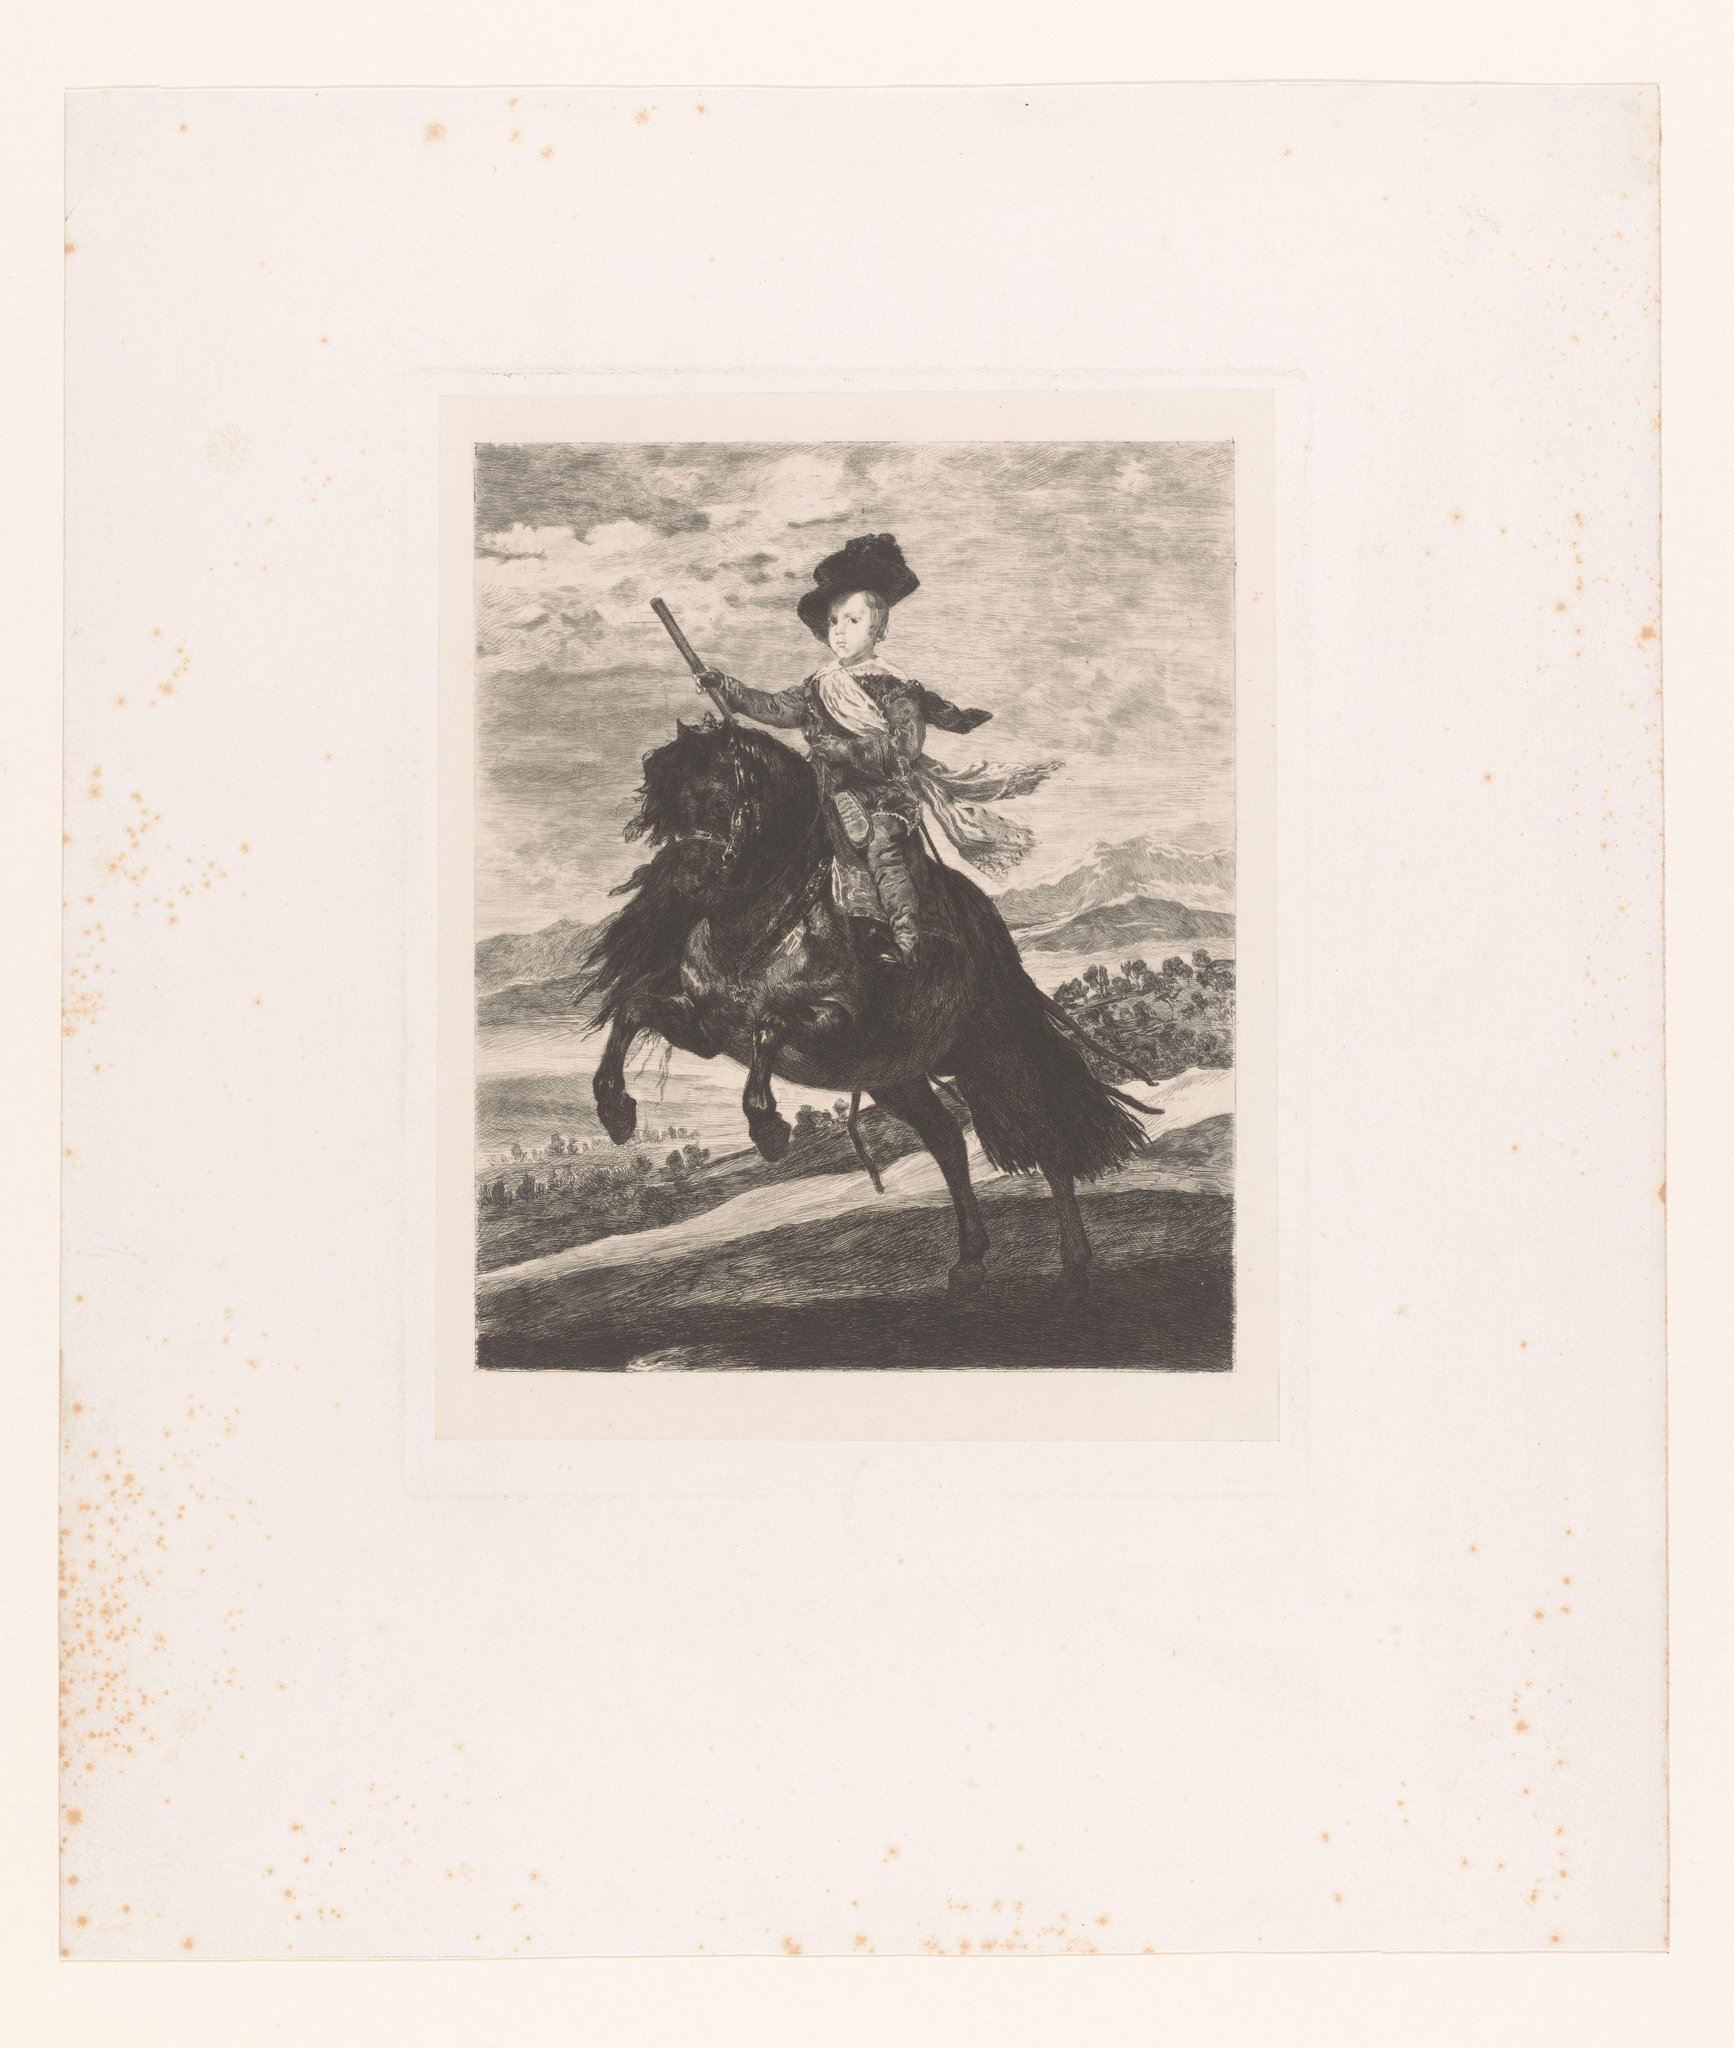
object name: print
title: Ruiterportret van Prins Balthasar Karel van Spanje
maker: léopold flameng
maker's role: print maker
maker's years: 1831-1911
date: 1841-1910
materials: paper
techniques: etching, intaglio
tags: equestrian state-portrait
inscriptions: collector's mark: Lugt 2228